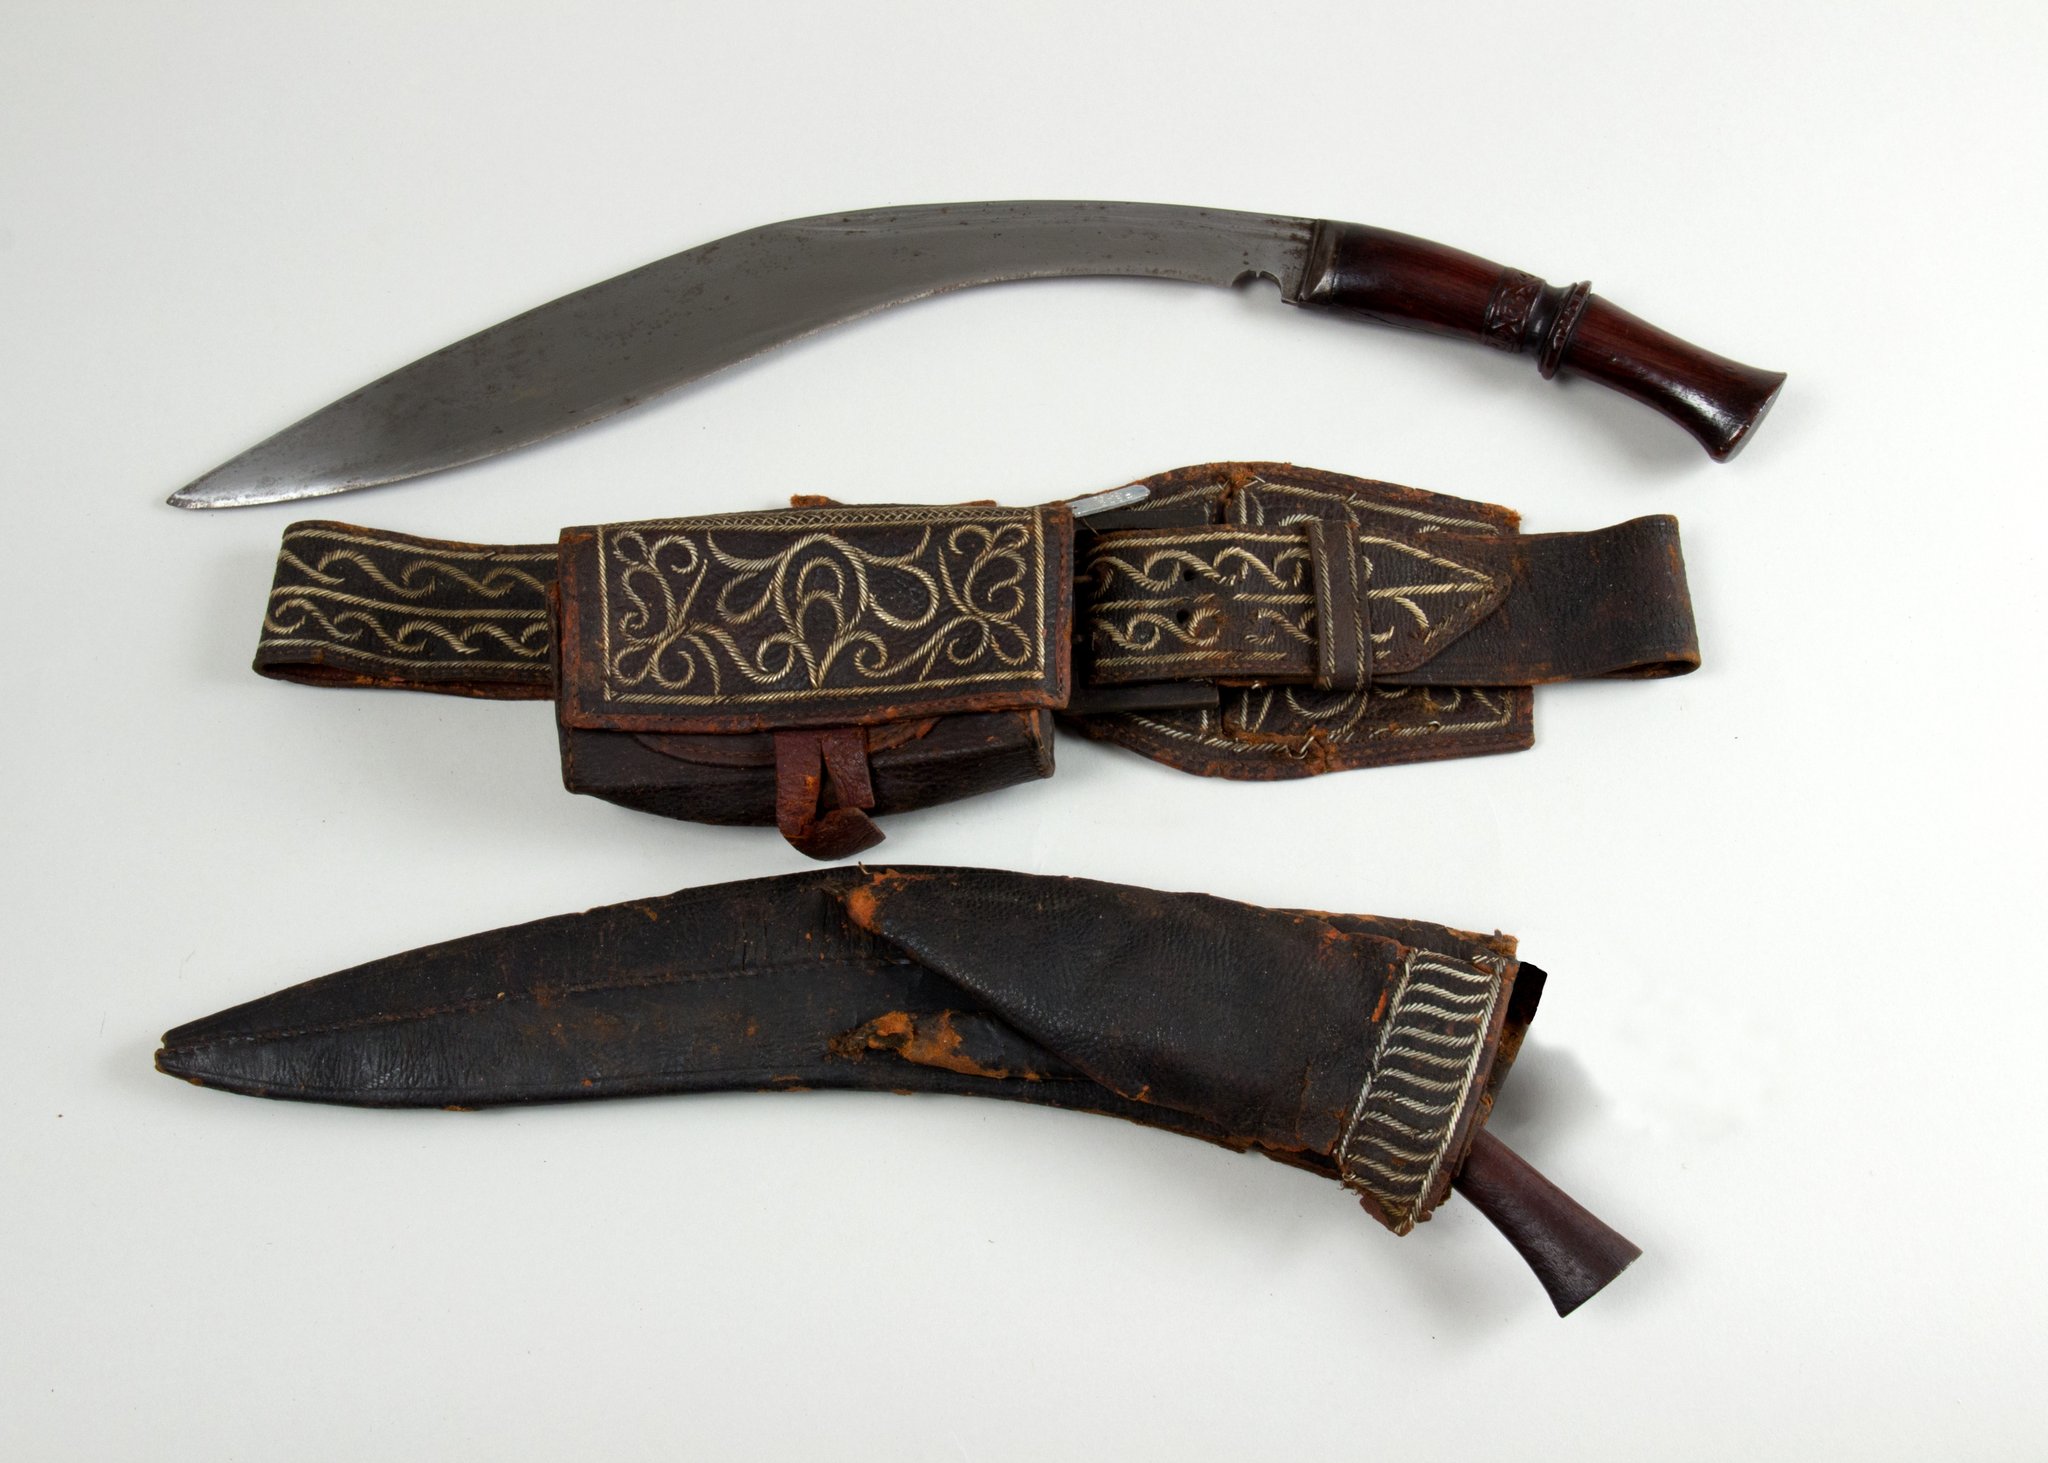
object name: knife kukri with sheath, two small knife and pouch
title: Knife (Kukri) with Sheath, Small Knife, Belt, Pouch and Box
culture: indian or nepalese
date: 1801-1900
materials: leather, steel, wood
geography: india